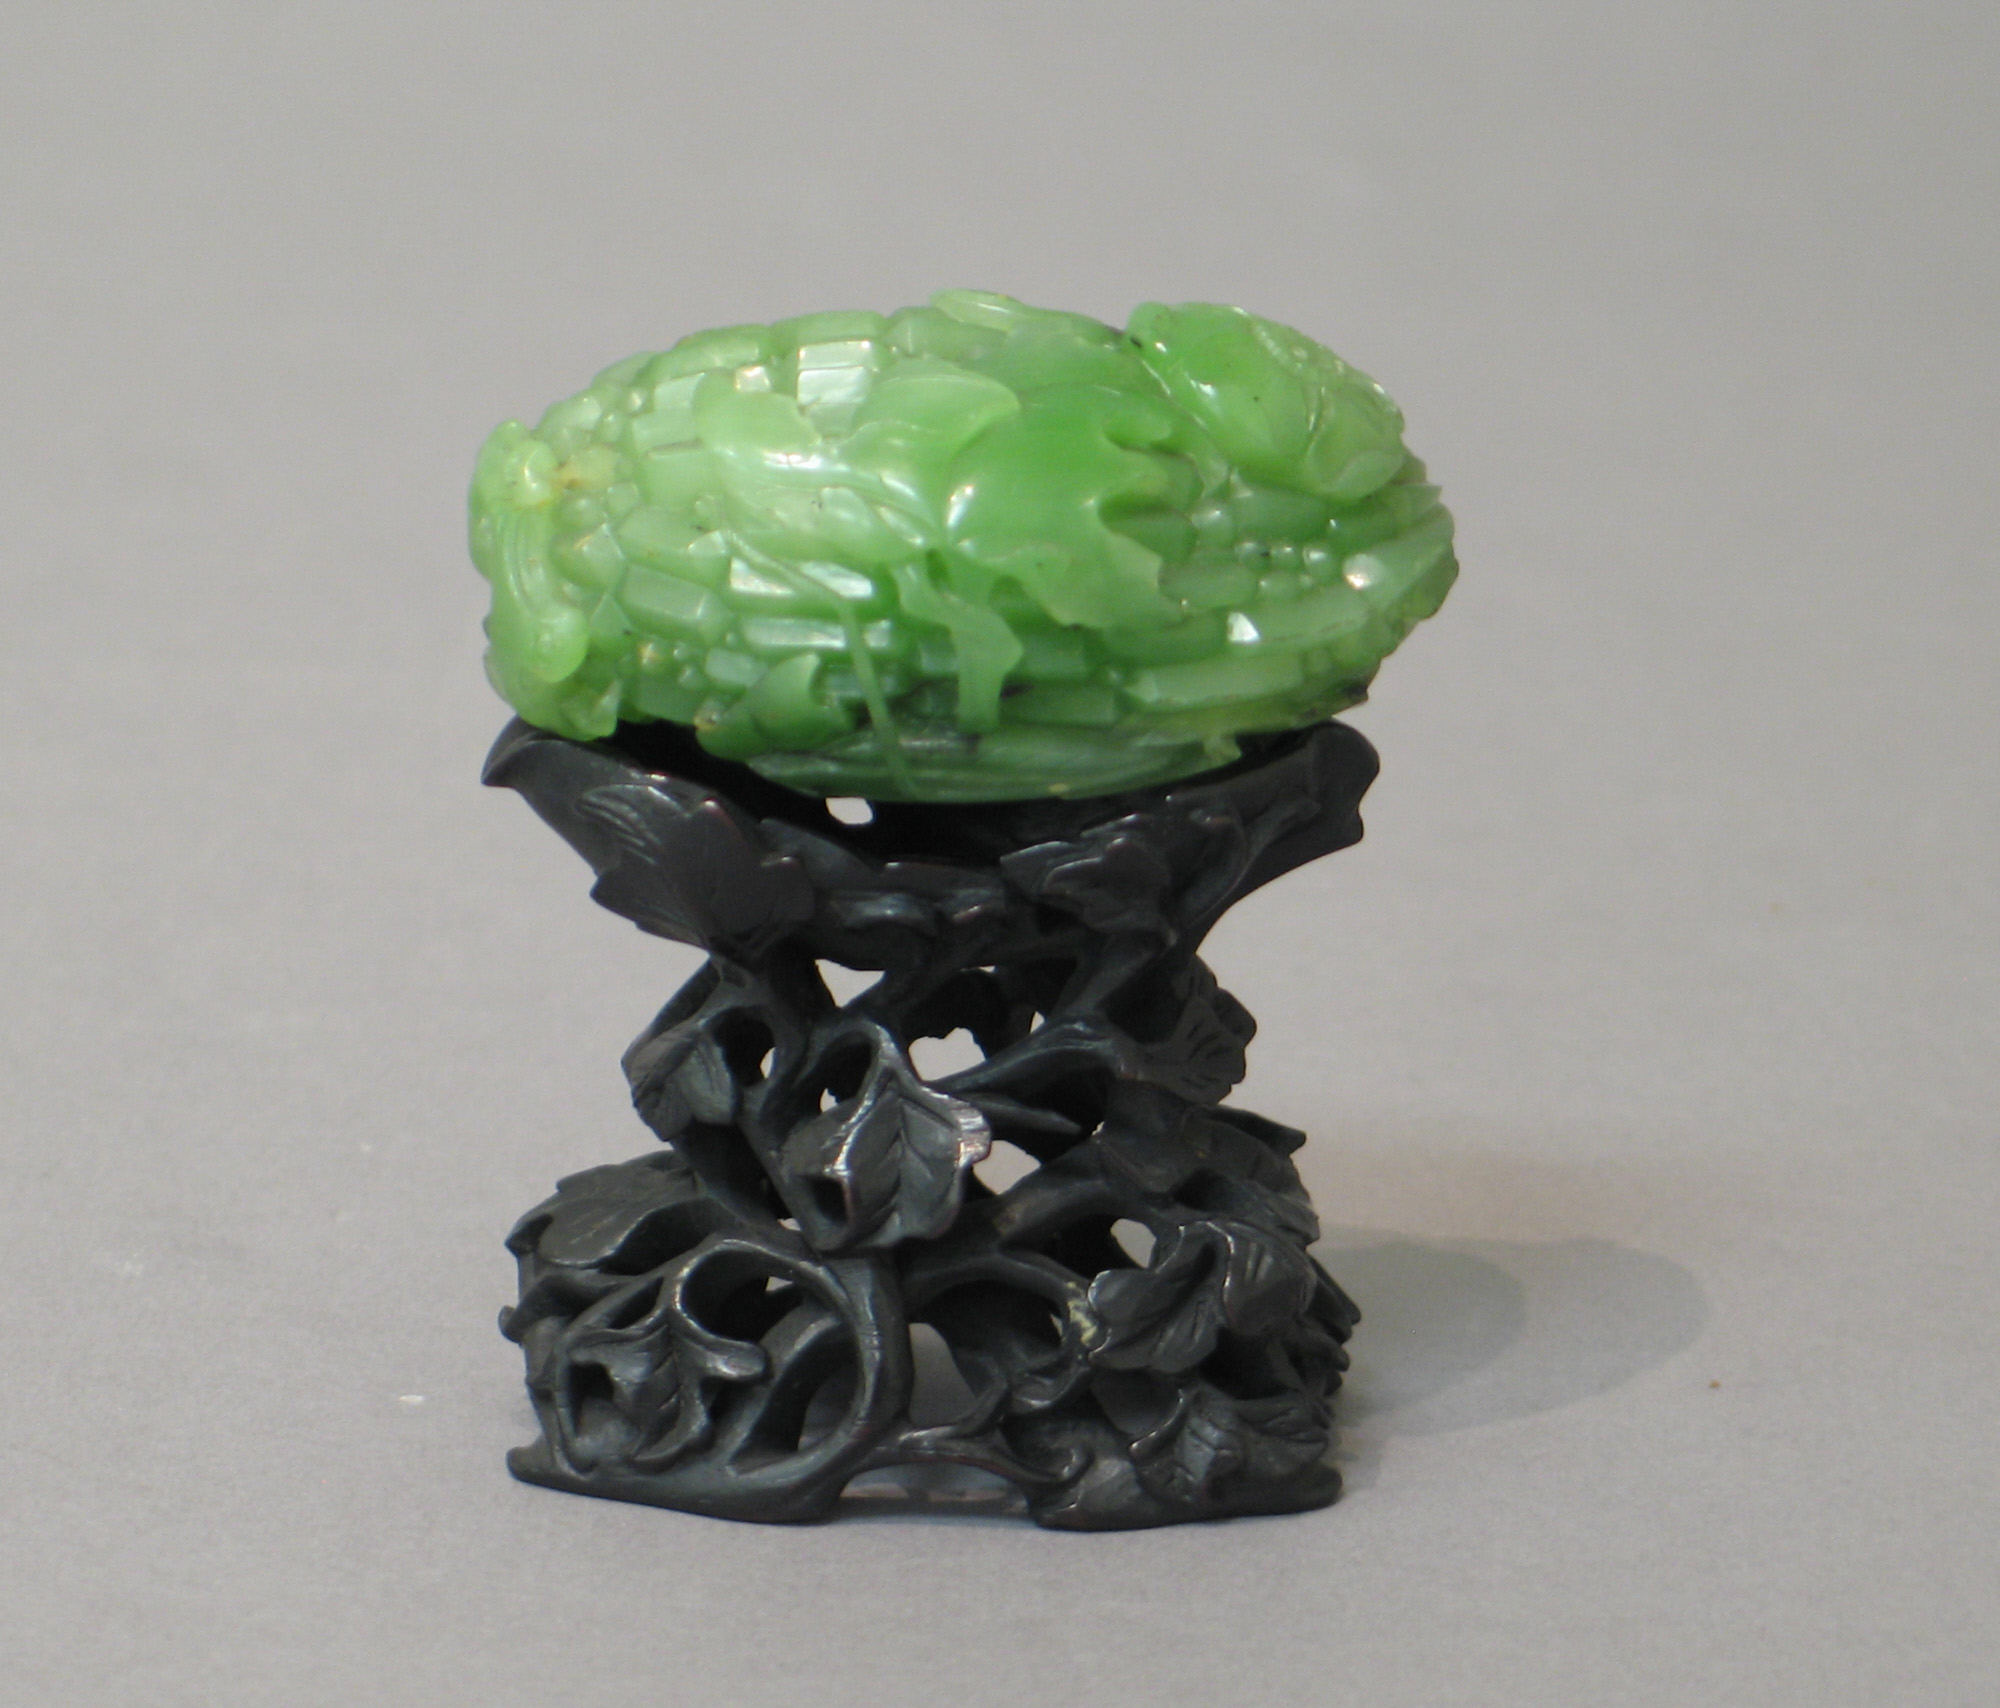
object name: paperweight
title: Paperweight in the shape of a bitter melon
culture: chinese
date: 1767-1833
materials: jade